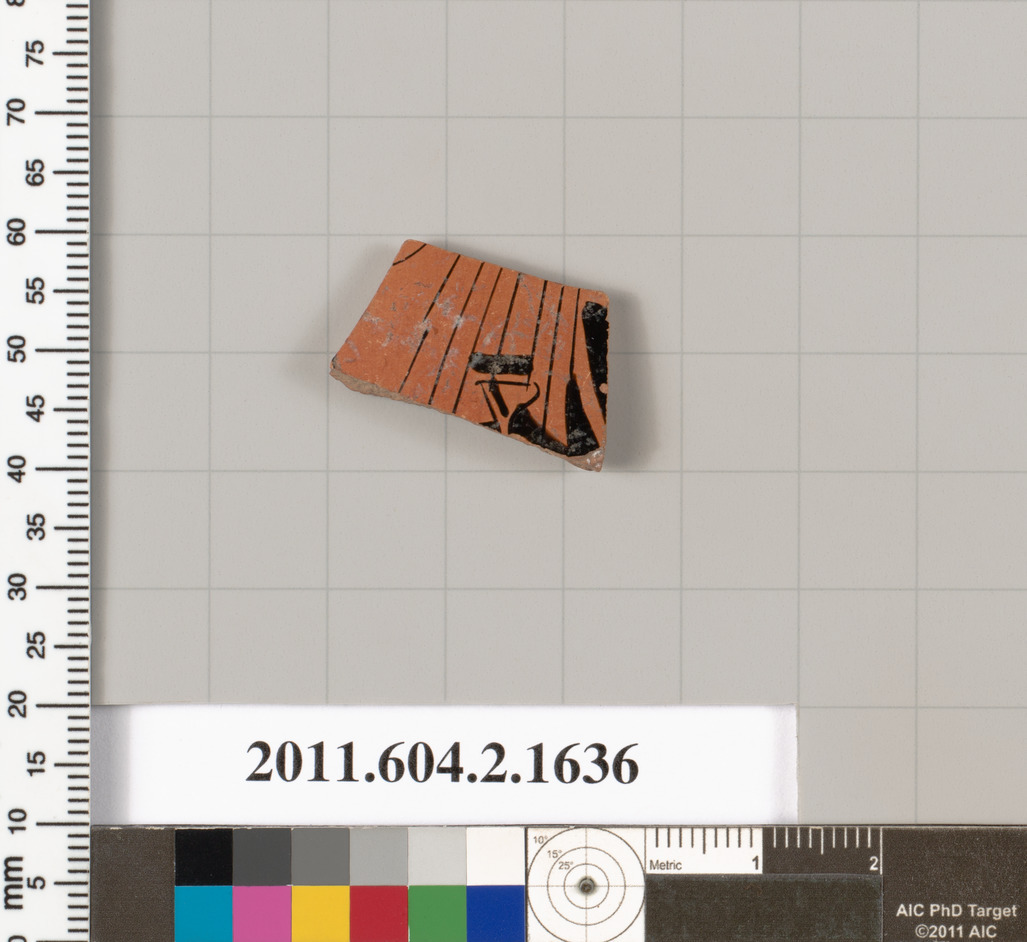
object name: skyphos fragment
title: Terracotta fragment of a skyphos (deep drinking cup)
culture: greek, attic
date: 475-451 BCE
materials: terracotta